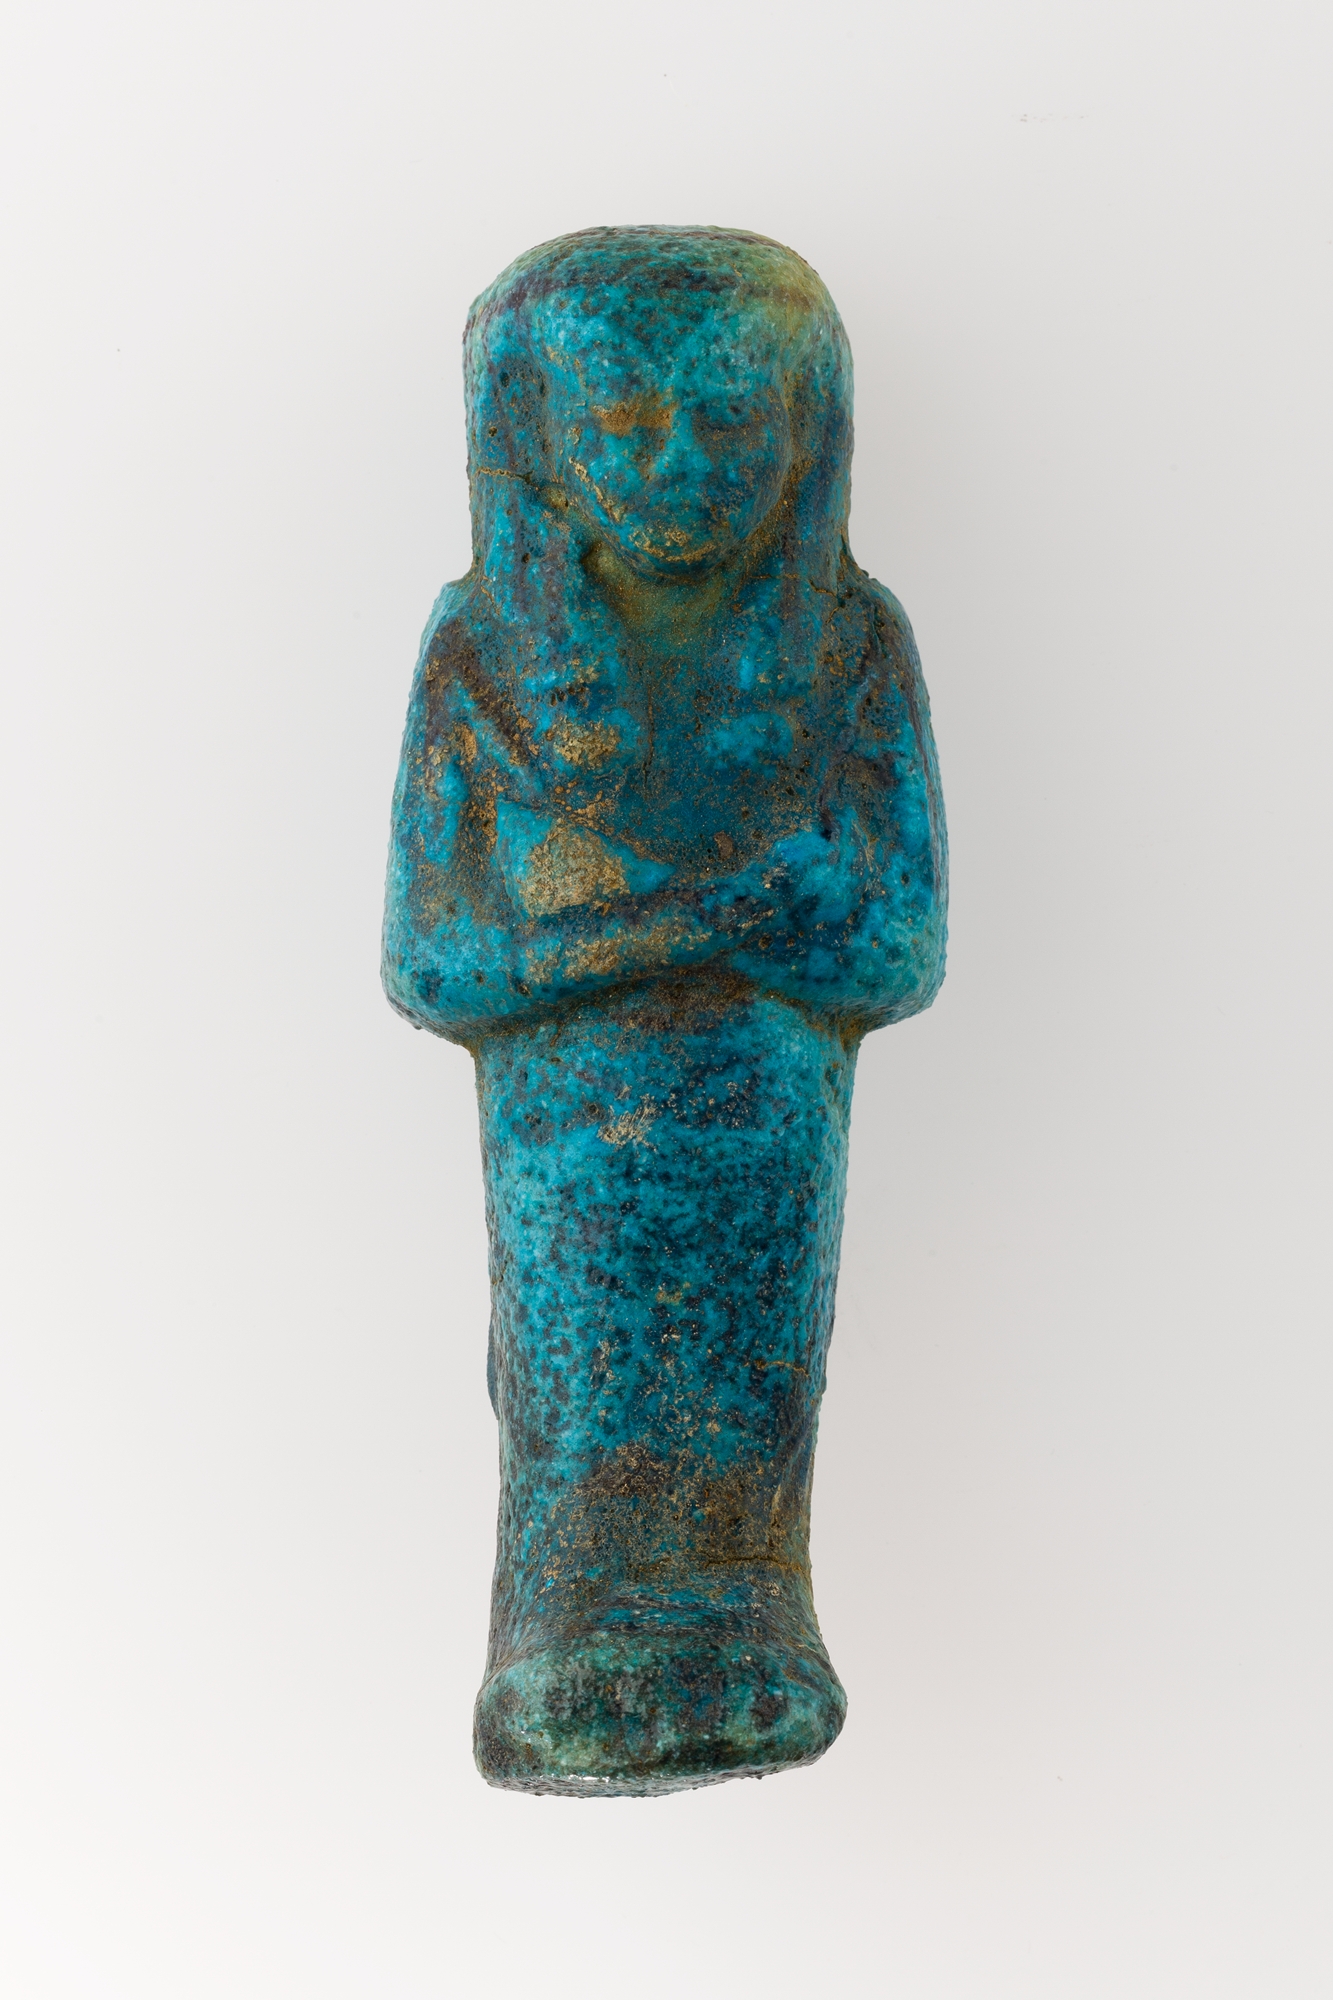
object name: shabti, henettawy c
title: Worker Shabti of Henettawy (C), Daughter of Isetemkheb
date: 990-970 BCE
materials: faience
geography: egypt